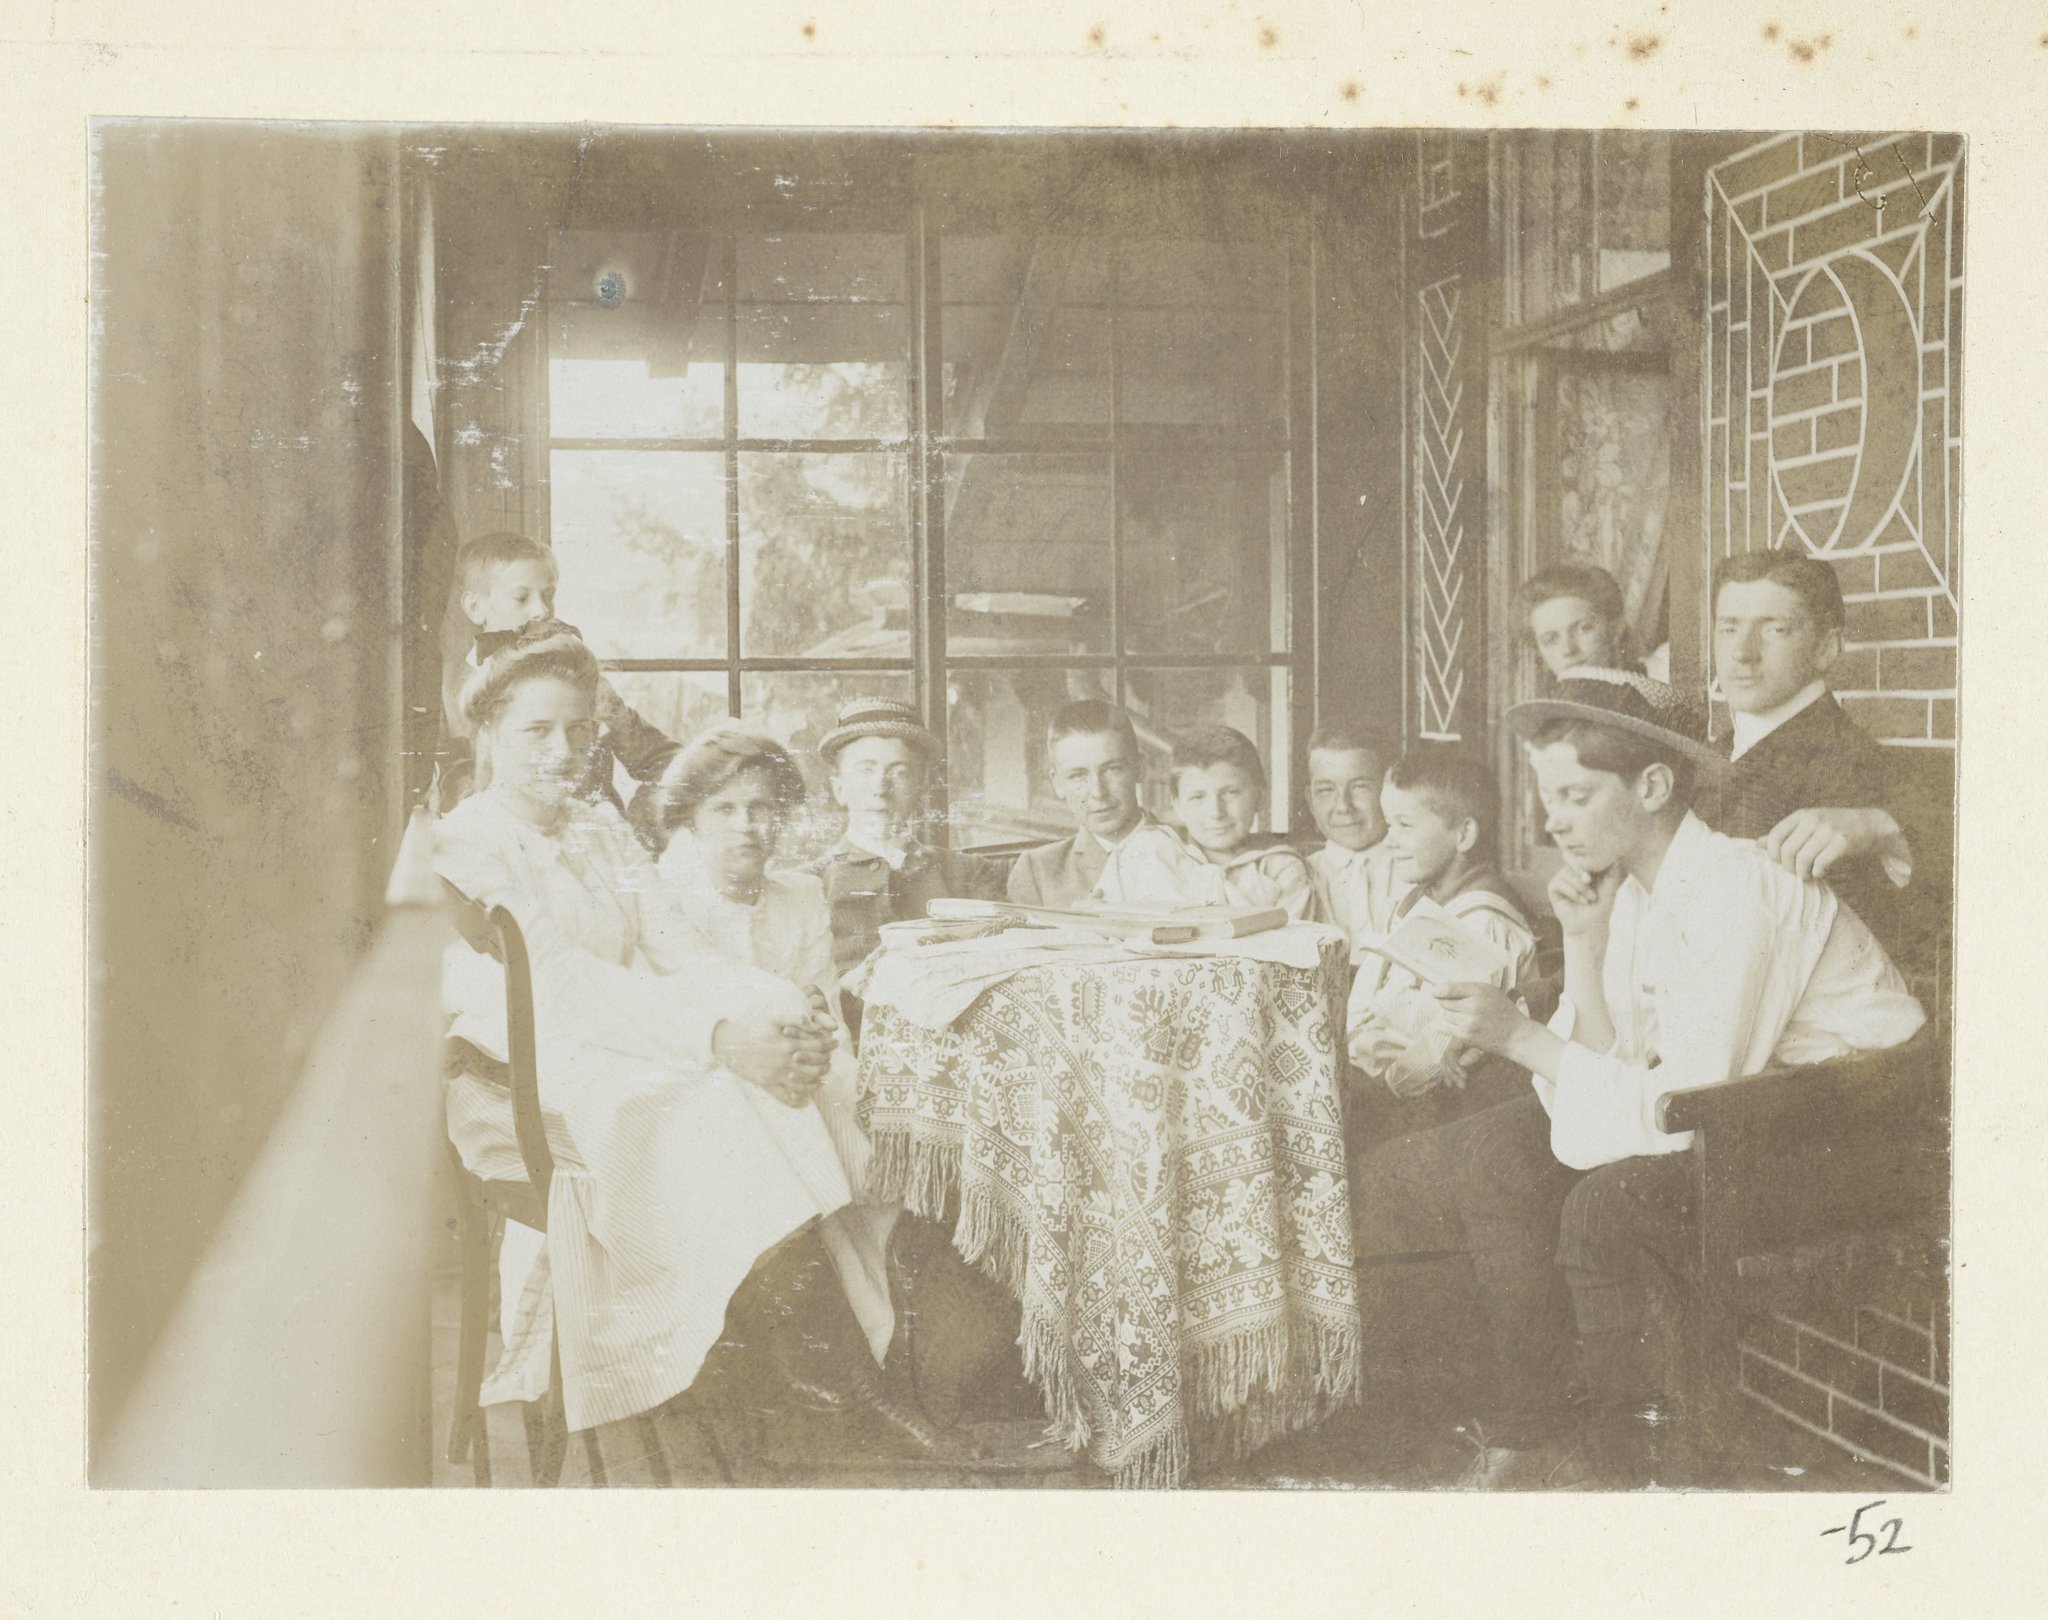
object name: photograph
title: De kinderen en jongelui van de familie Kessler op het balkon van het vakantiehuis, vermoedelijk in de Harz. Ze zitten rond een tafel met boeken en schrijfgerei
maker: geldolph adriaan kessler (dolph)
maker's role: fotograaf, industrieel, voetballer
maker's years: 1884-1945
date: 1903-1908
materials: cardboard, photographic support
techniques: gelatin silver print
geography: harz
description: De kinderen en jongelui van de familie Kessler op het balkon van het vakantiehuis, vermoedelijk in de Harz. Ze zitten rond een tafel met boeken en schrijfgerei. Onderdeel van het fotoalbum van Dolph Kessler met opnamen die hij maakte tijdens zijn verblijf in Engeland en op een wereldreis die hij als secretaris van Henri Deterding (directeur Koninklijke Olie) ondernam naar Nederlands-Indië, Japan, China en de Verenigde Staten, tussen 1906 en 1908.